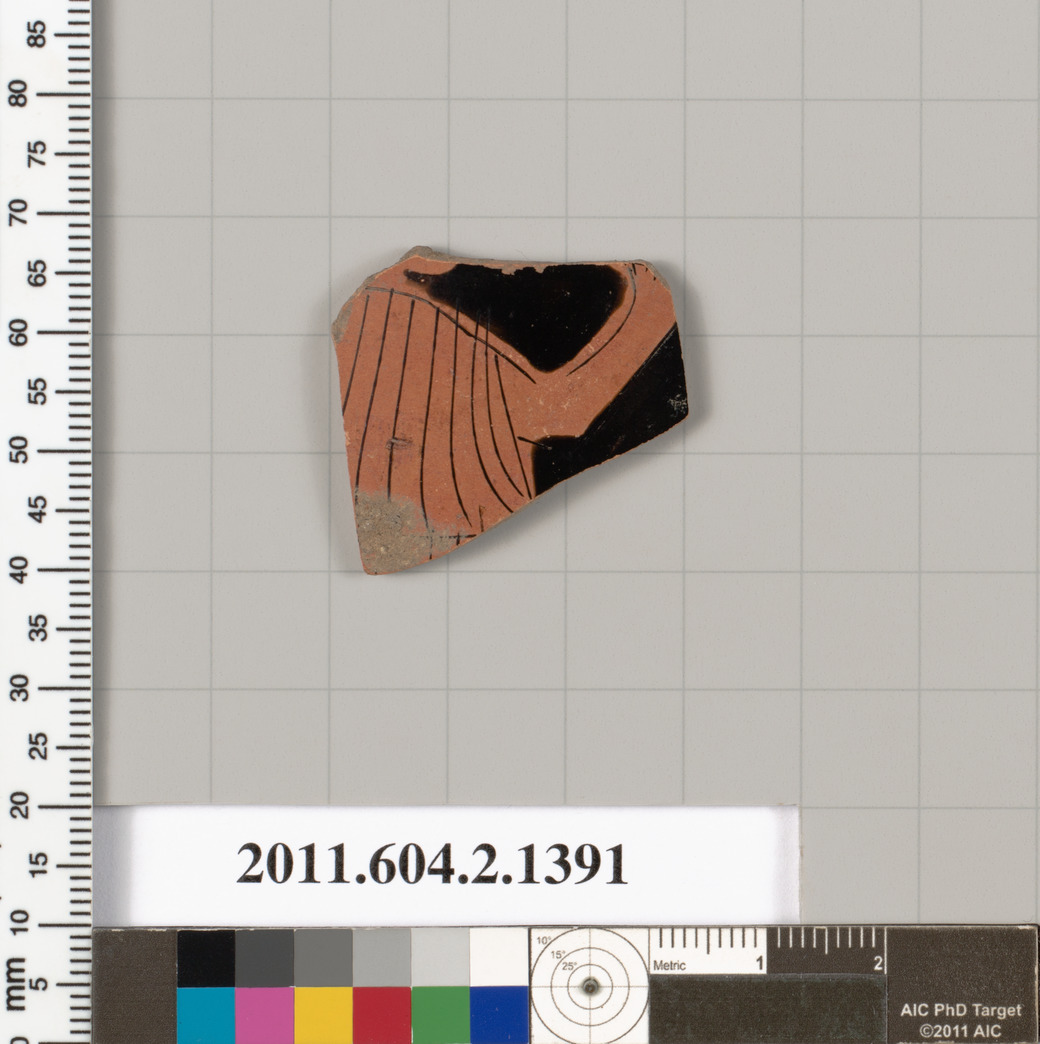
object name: skyphos fragment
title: Terracotta fragment of a skyphos (deep drinking cup)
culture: greek, attic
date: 450-440 BCE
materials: terracotta